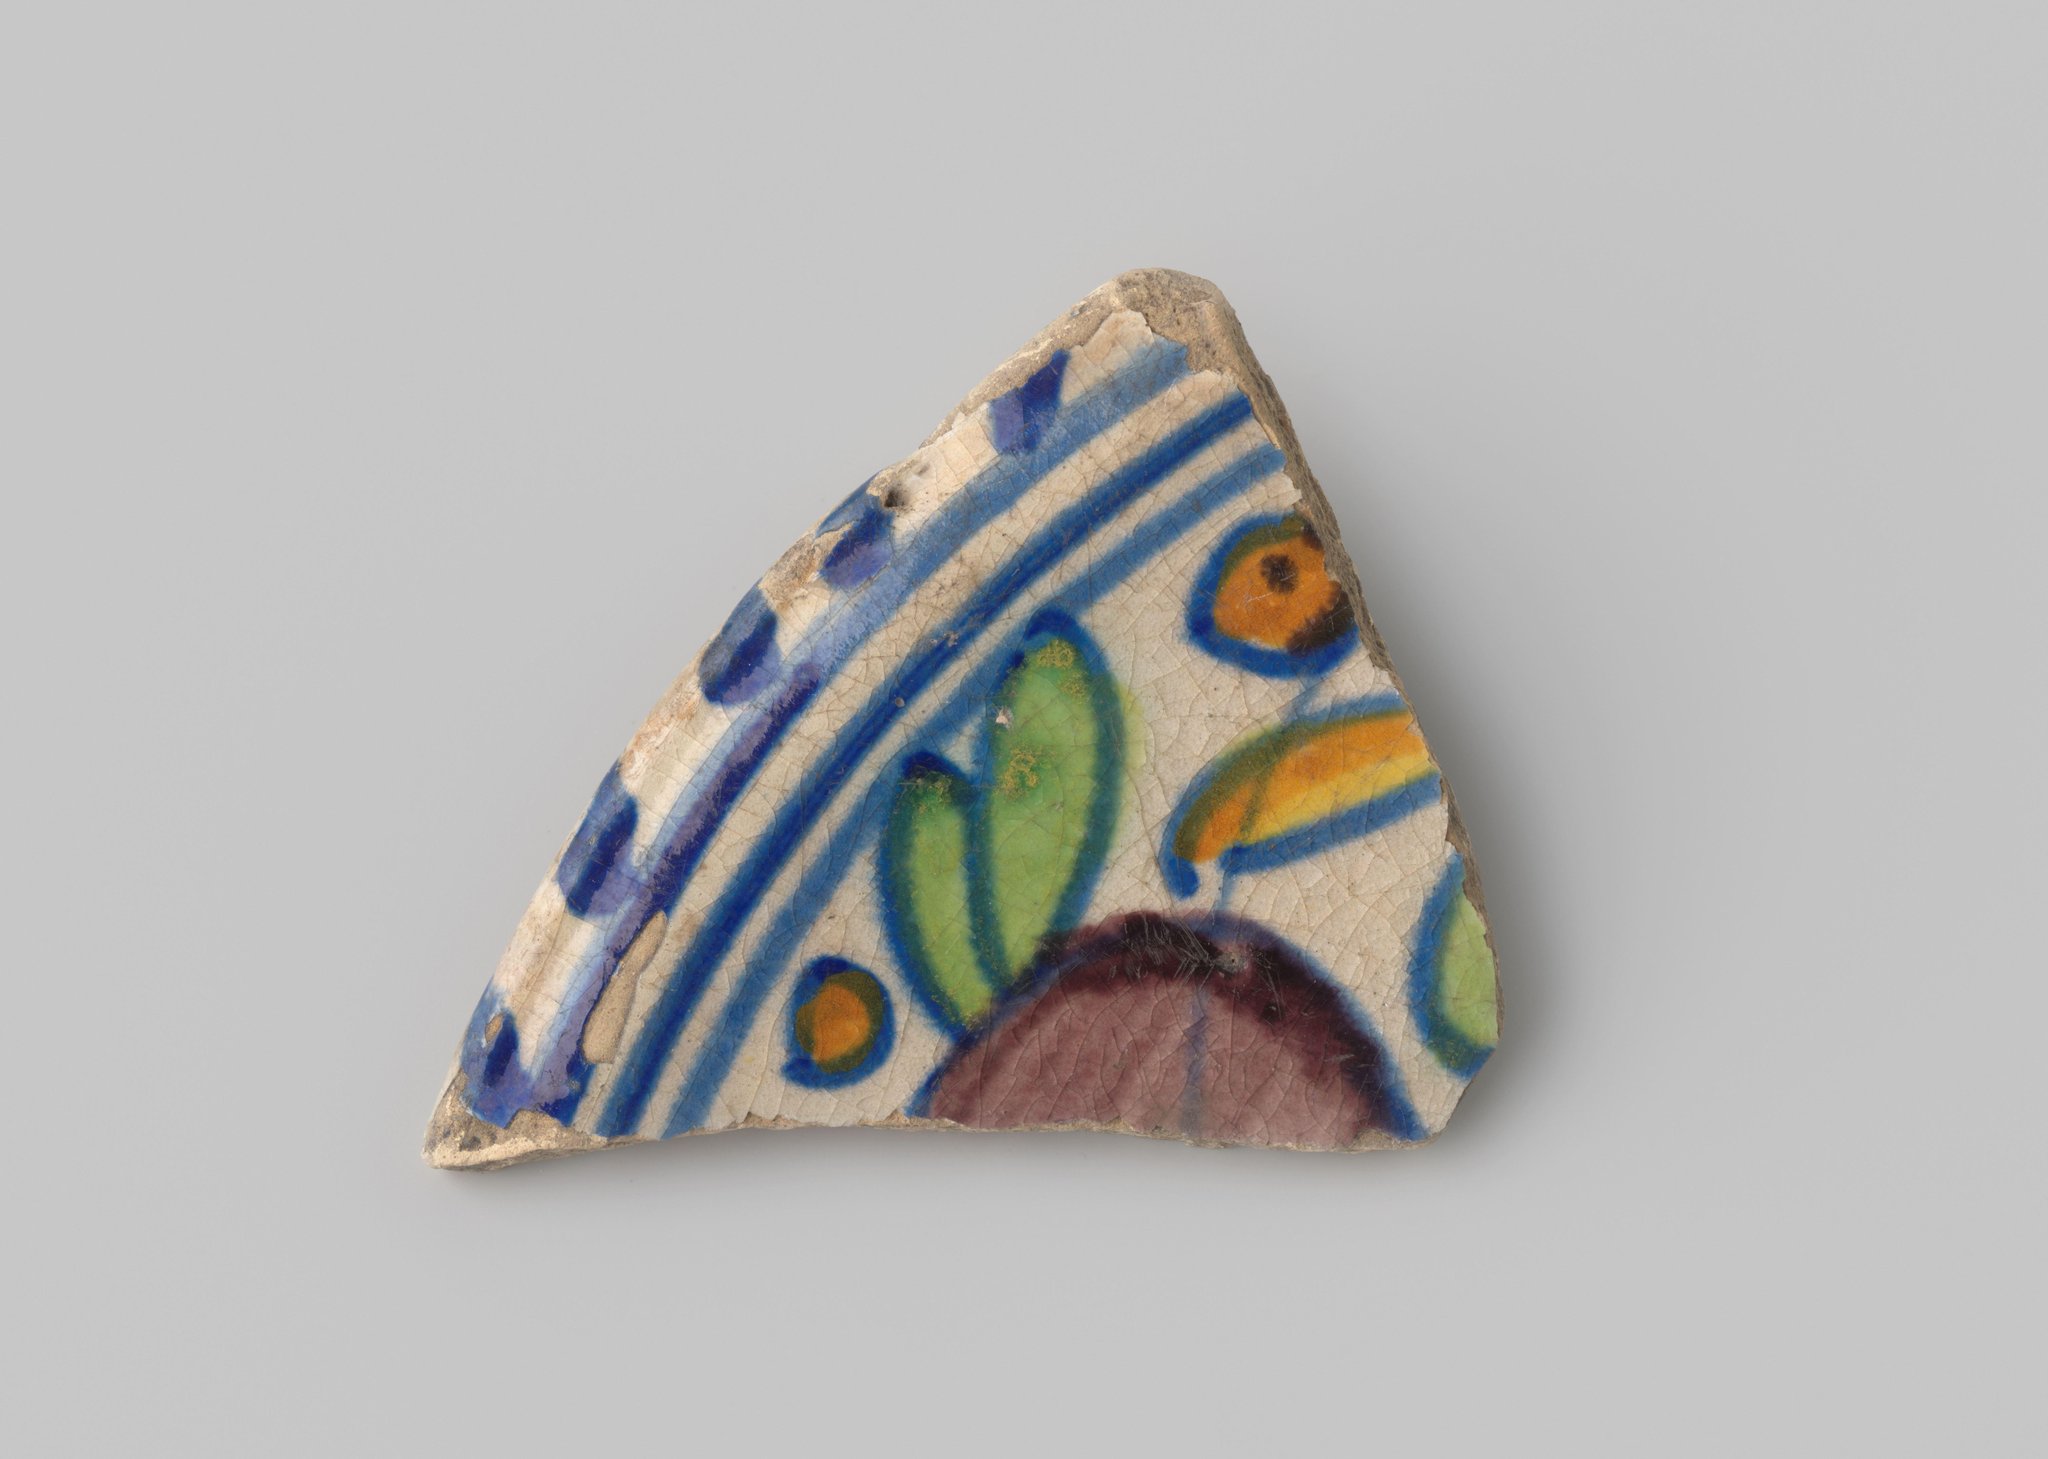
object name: sherd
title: Scherf veelkleurig majolica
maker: Anonymous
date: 1500-1699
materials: earthenware, glaze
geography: northern netherlands